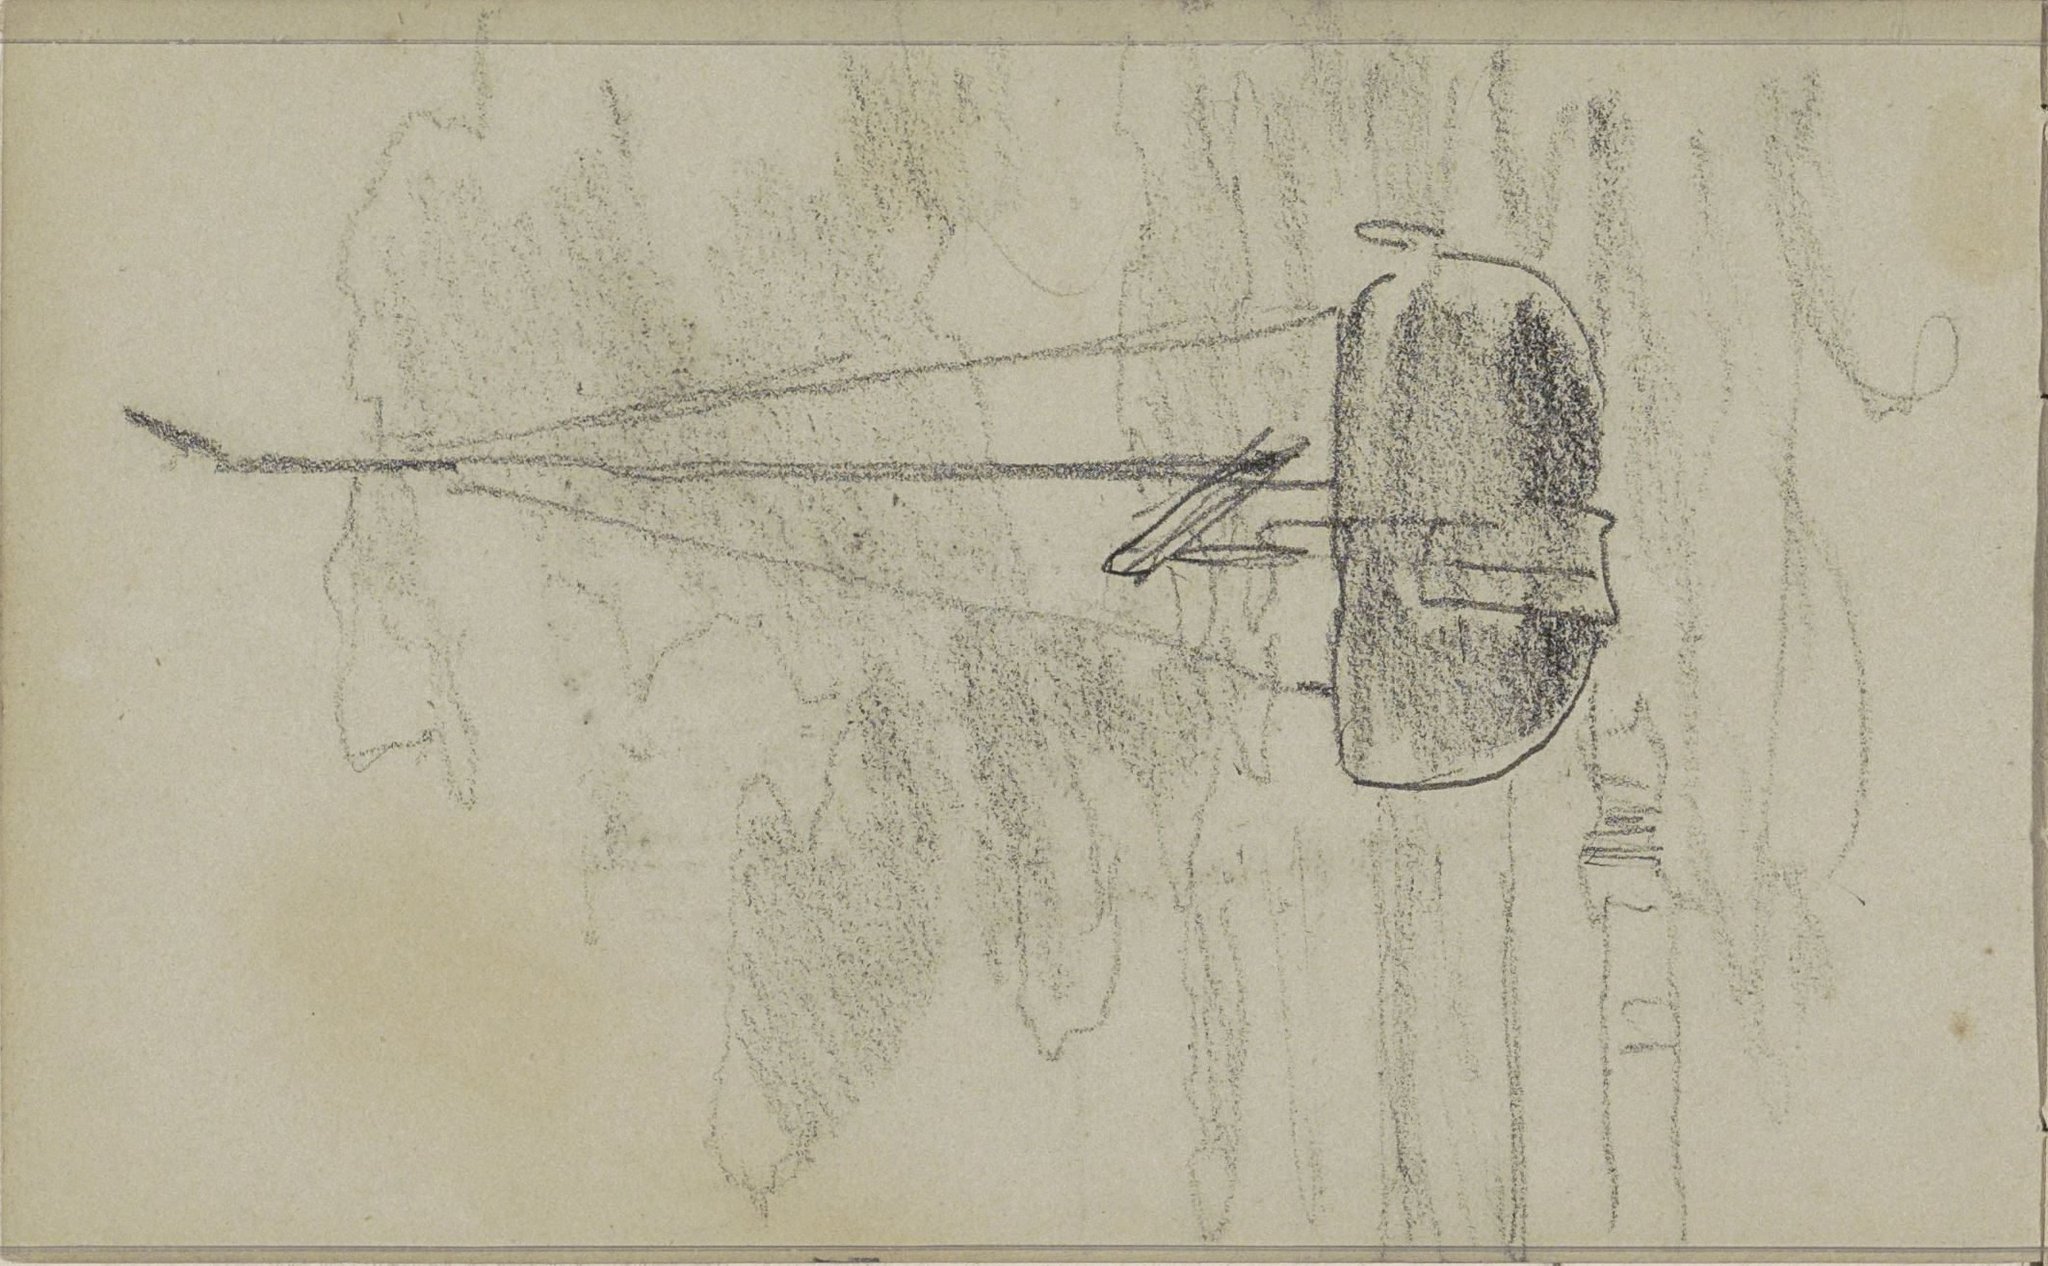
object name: sketchbook leaf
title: Zeilschip op het strand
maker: anton mauve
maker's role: draughtsman, painter, print maker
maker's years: 1838-1888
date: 1848-1888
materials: paper, pencil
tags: sailing-ship, sailing-boat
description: Mogelijk een bomschuit. Blad 33 verso uit een schetsboek met 43 bladen.